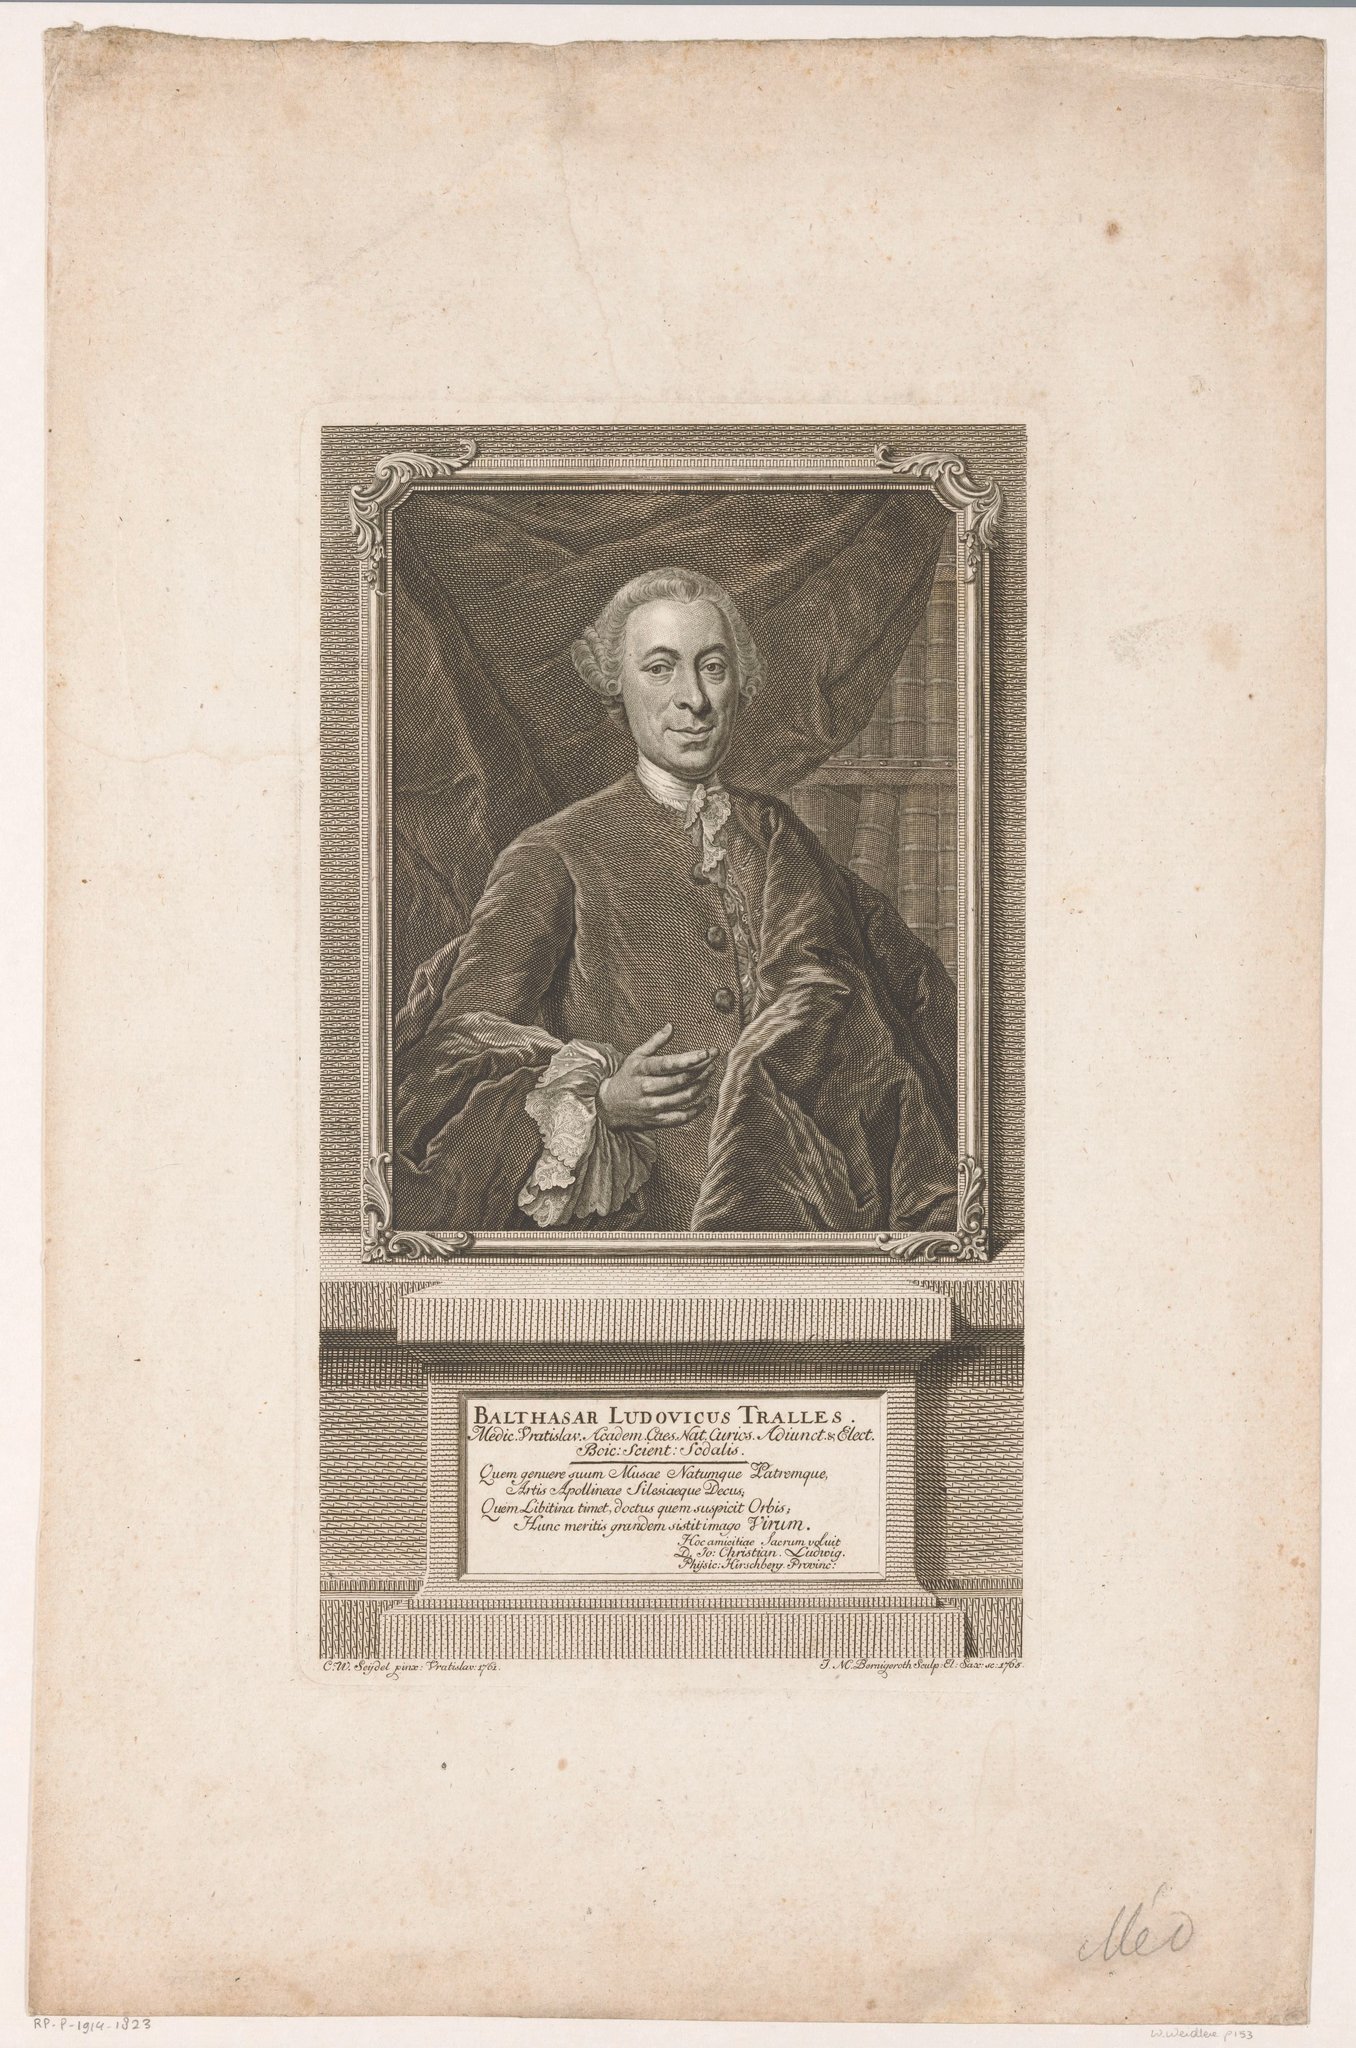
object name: print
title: Portret van Balthasar Ludwig Tralles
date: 1765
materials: paper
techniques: engraving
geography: wroclaw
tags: bookshelves, historical persons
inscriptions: collector's mark: Lugt 2228